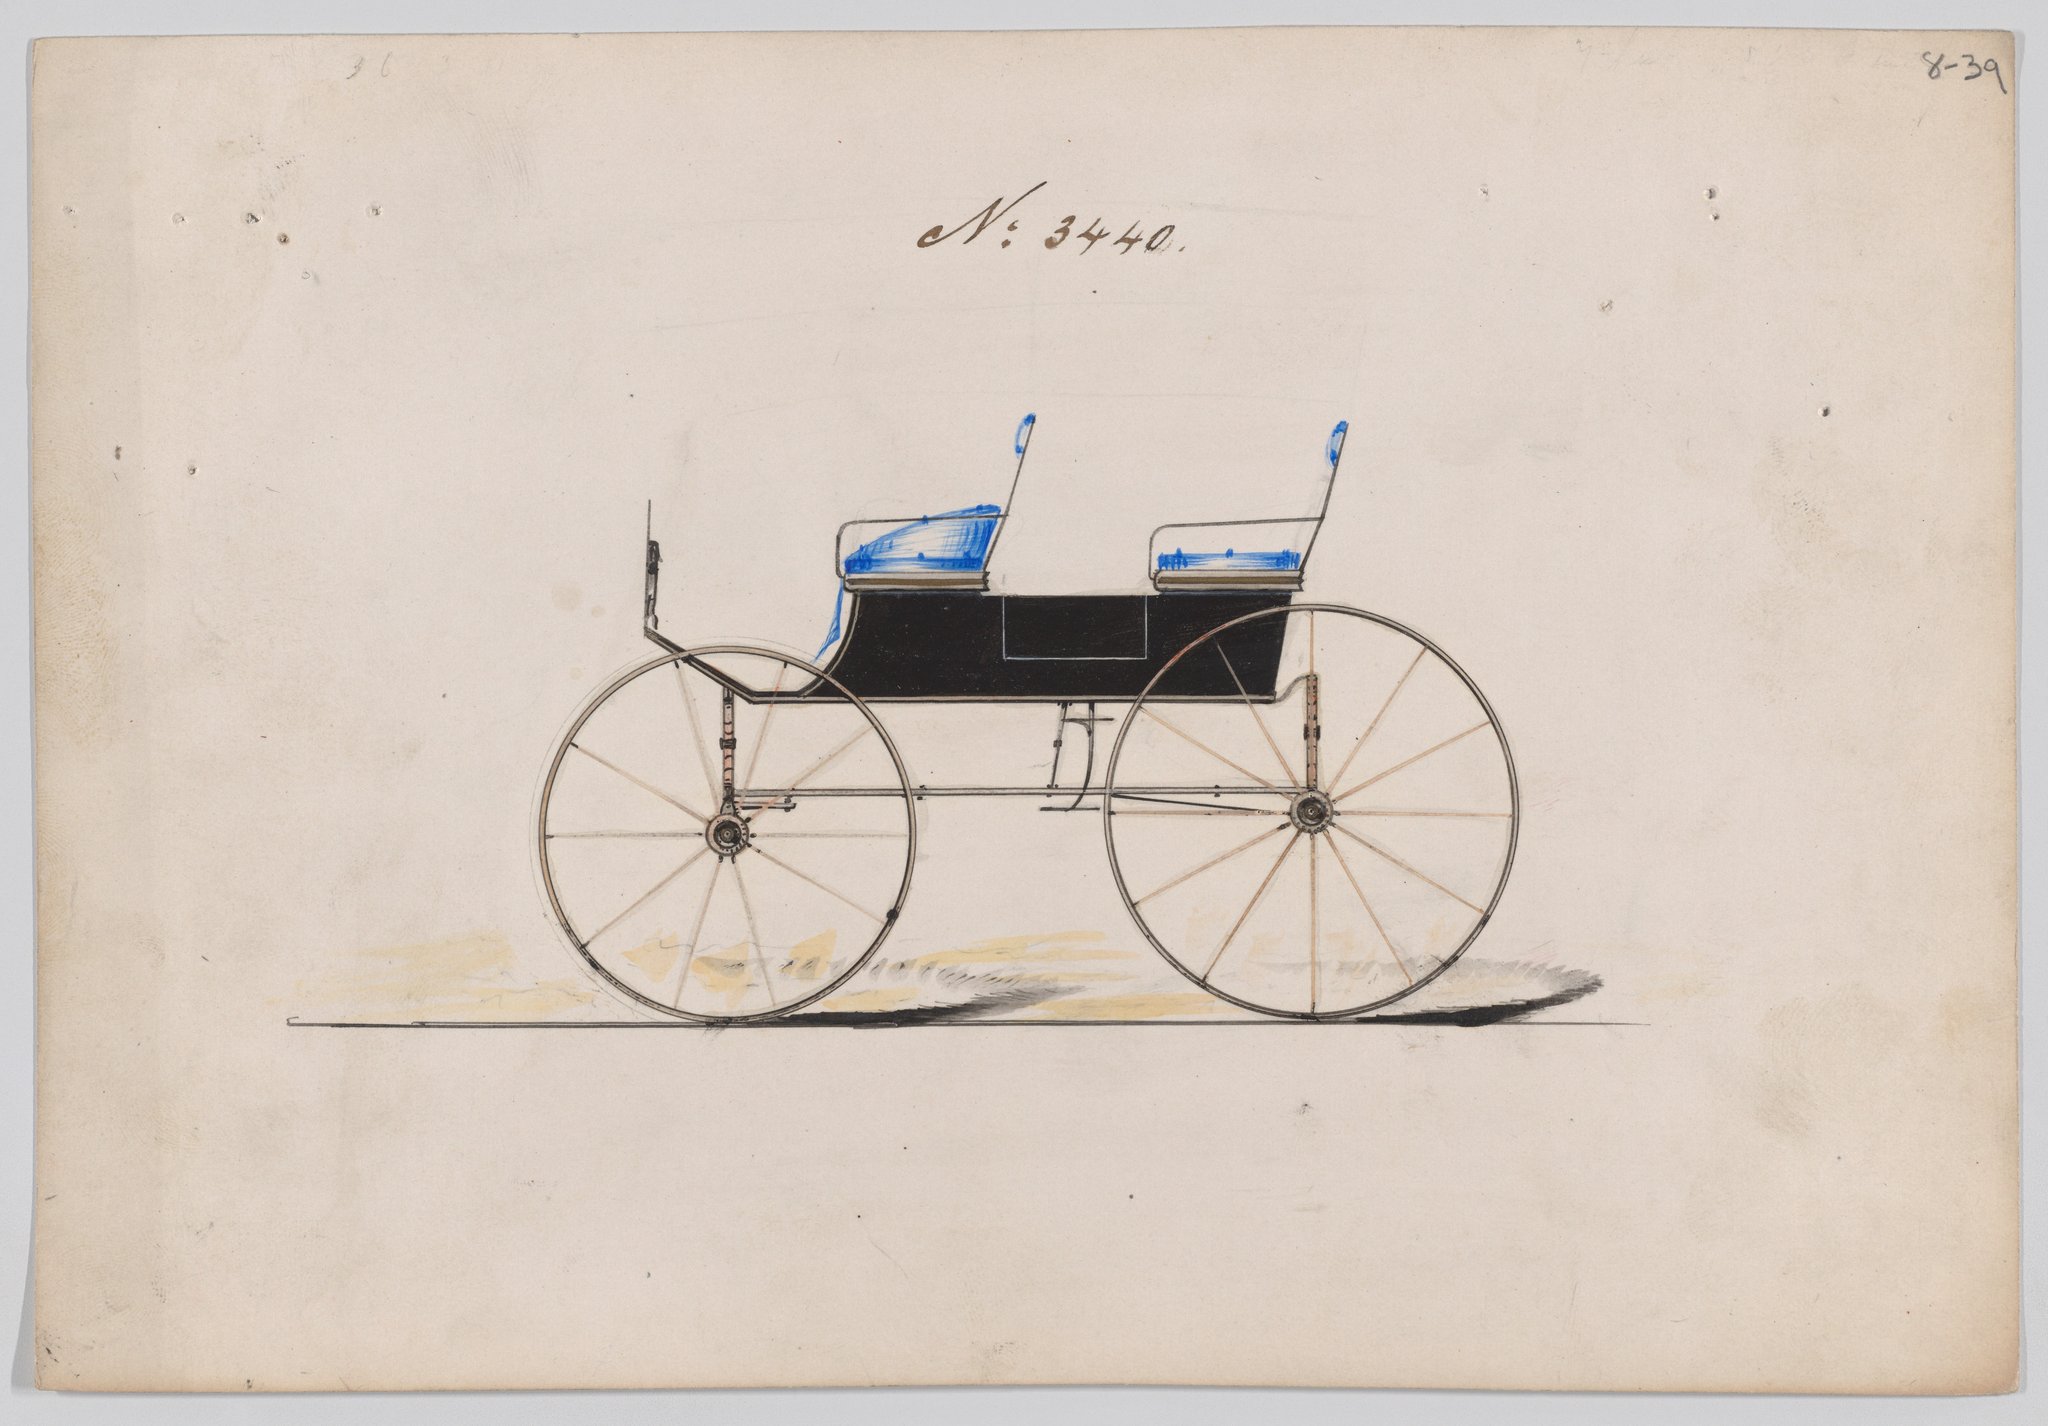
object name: drawing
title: Design for 4 seat Phaeton, no top, no. 3440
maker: brewster & co.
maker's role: manufacturer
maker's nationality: american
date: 1878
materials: gouache, gum arabic, ink, watercolor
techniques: pen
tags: carriages